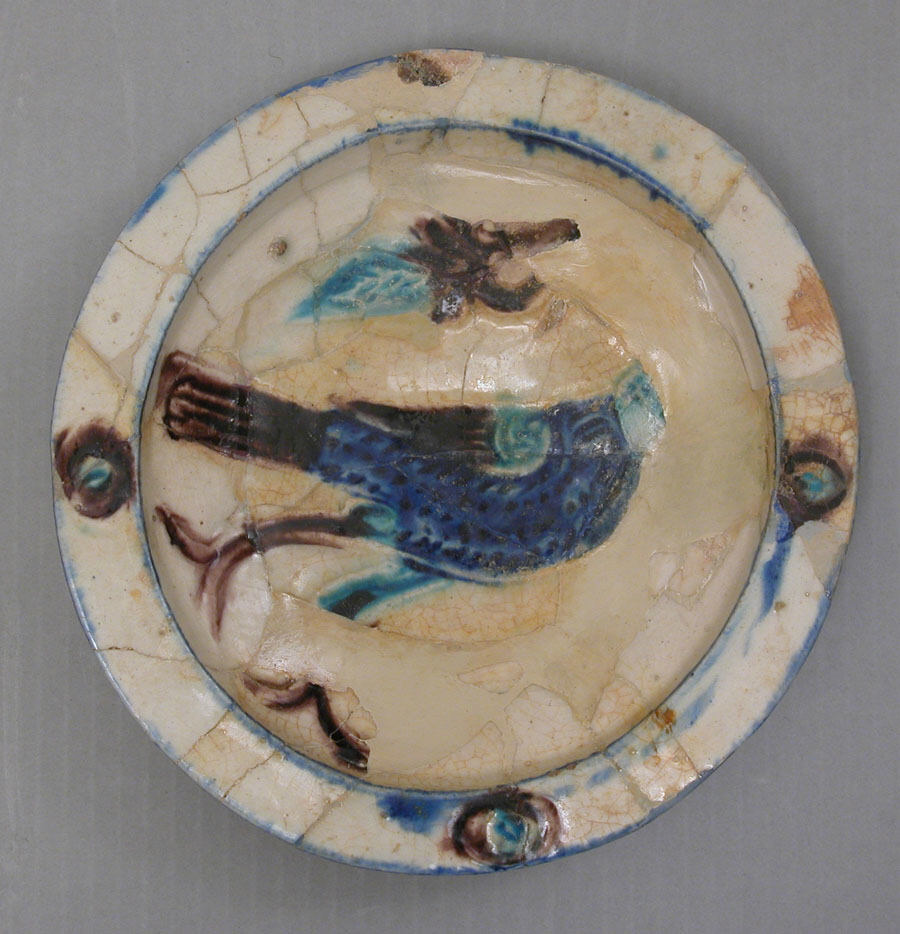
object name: bowl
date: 1101-1200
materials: stonepaste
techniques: glazing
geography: syria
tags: birds